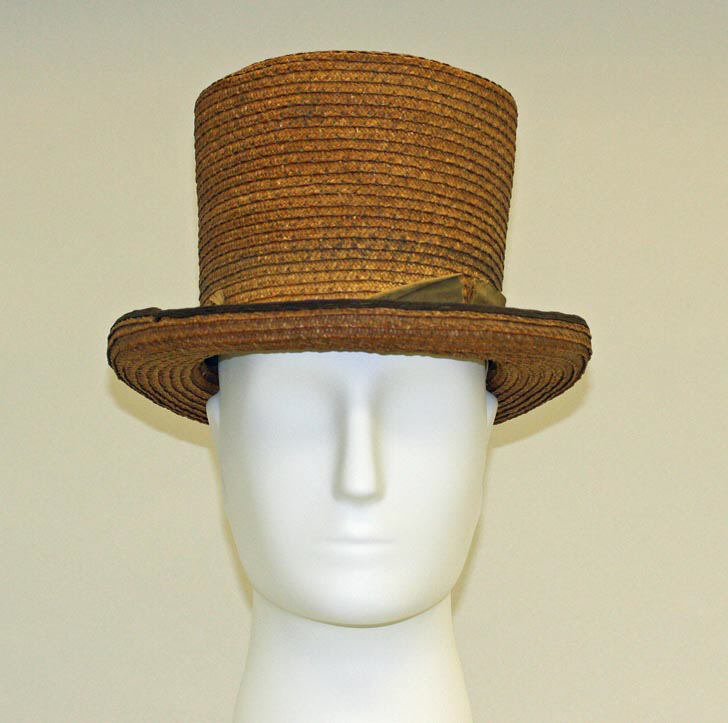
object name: hat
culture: american or european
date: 1840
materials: fiber